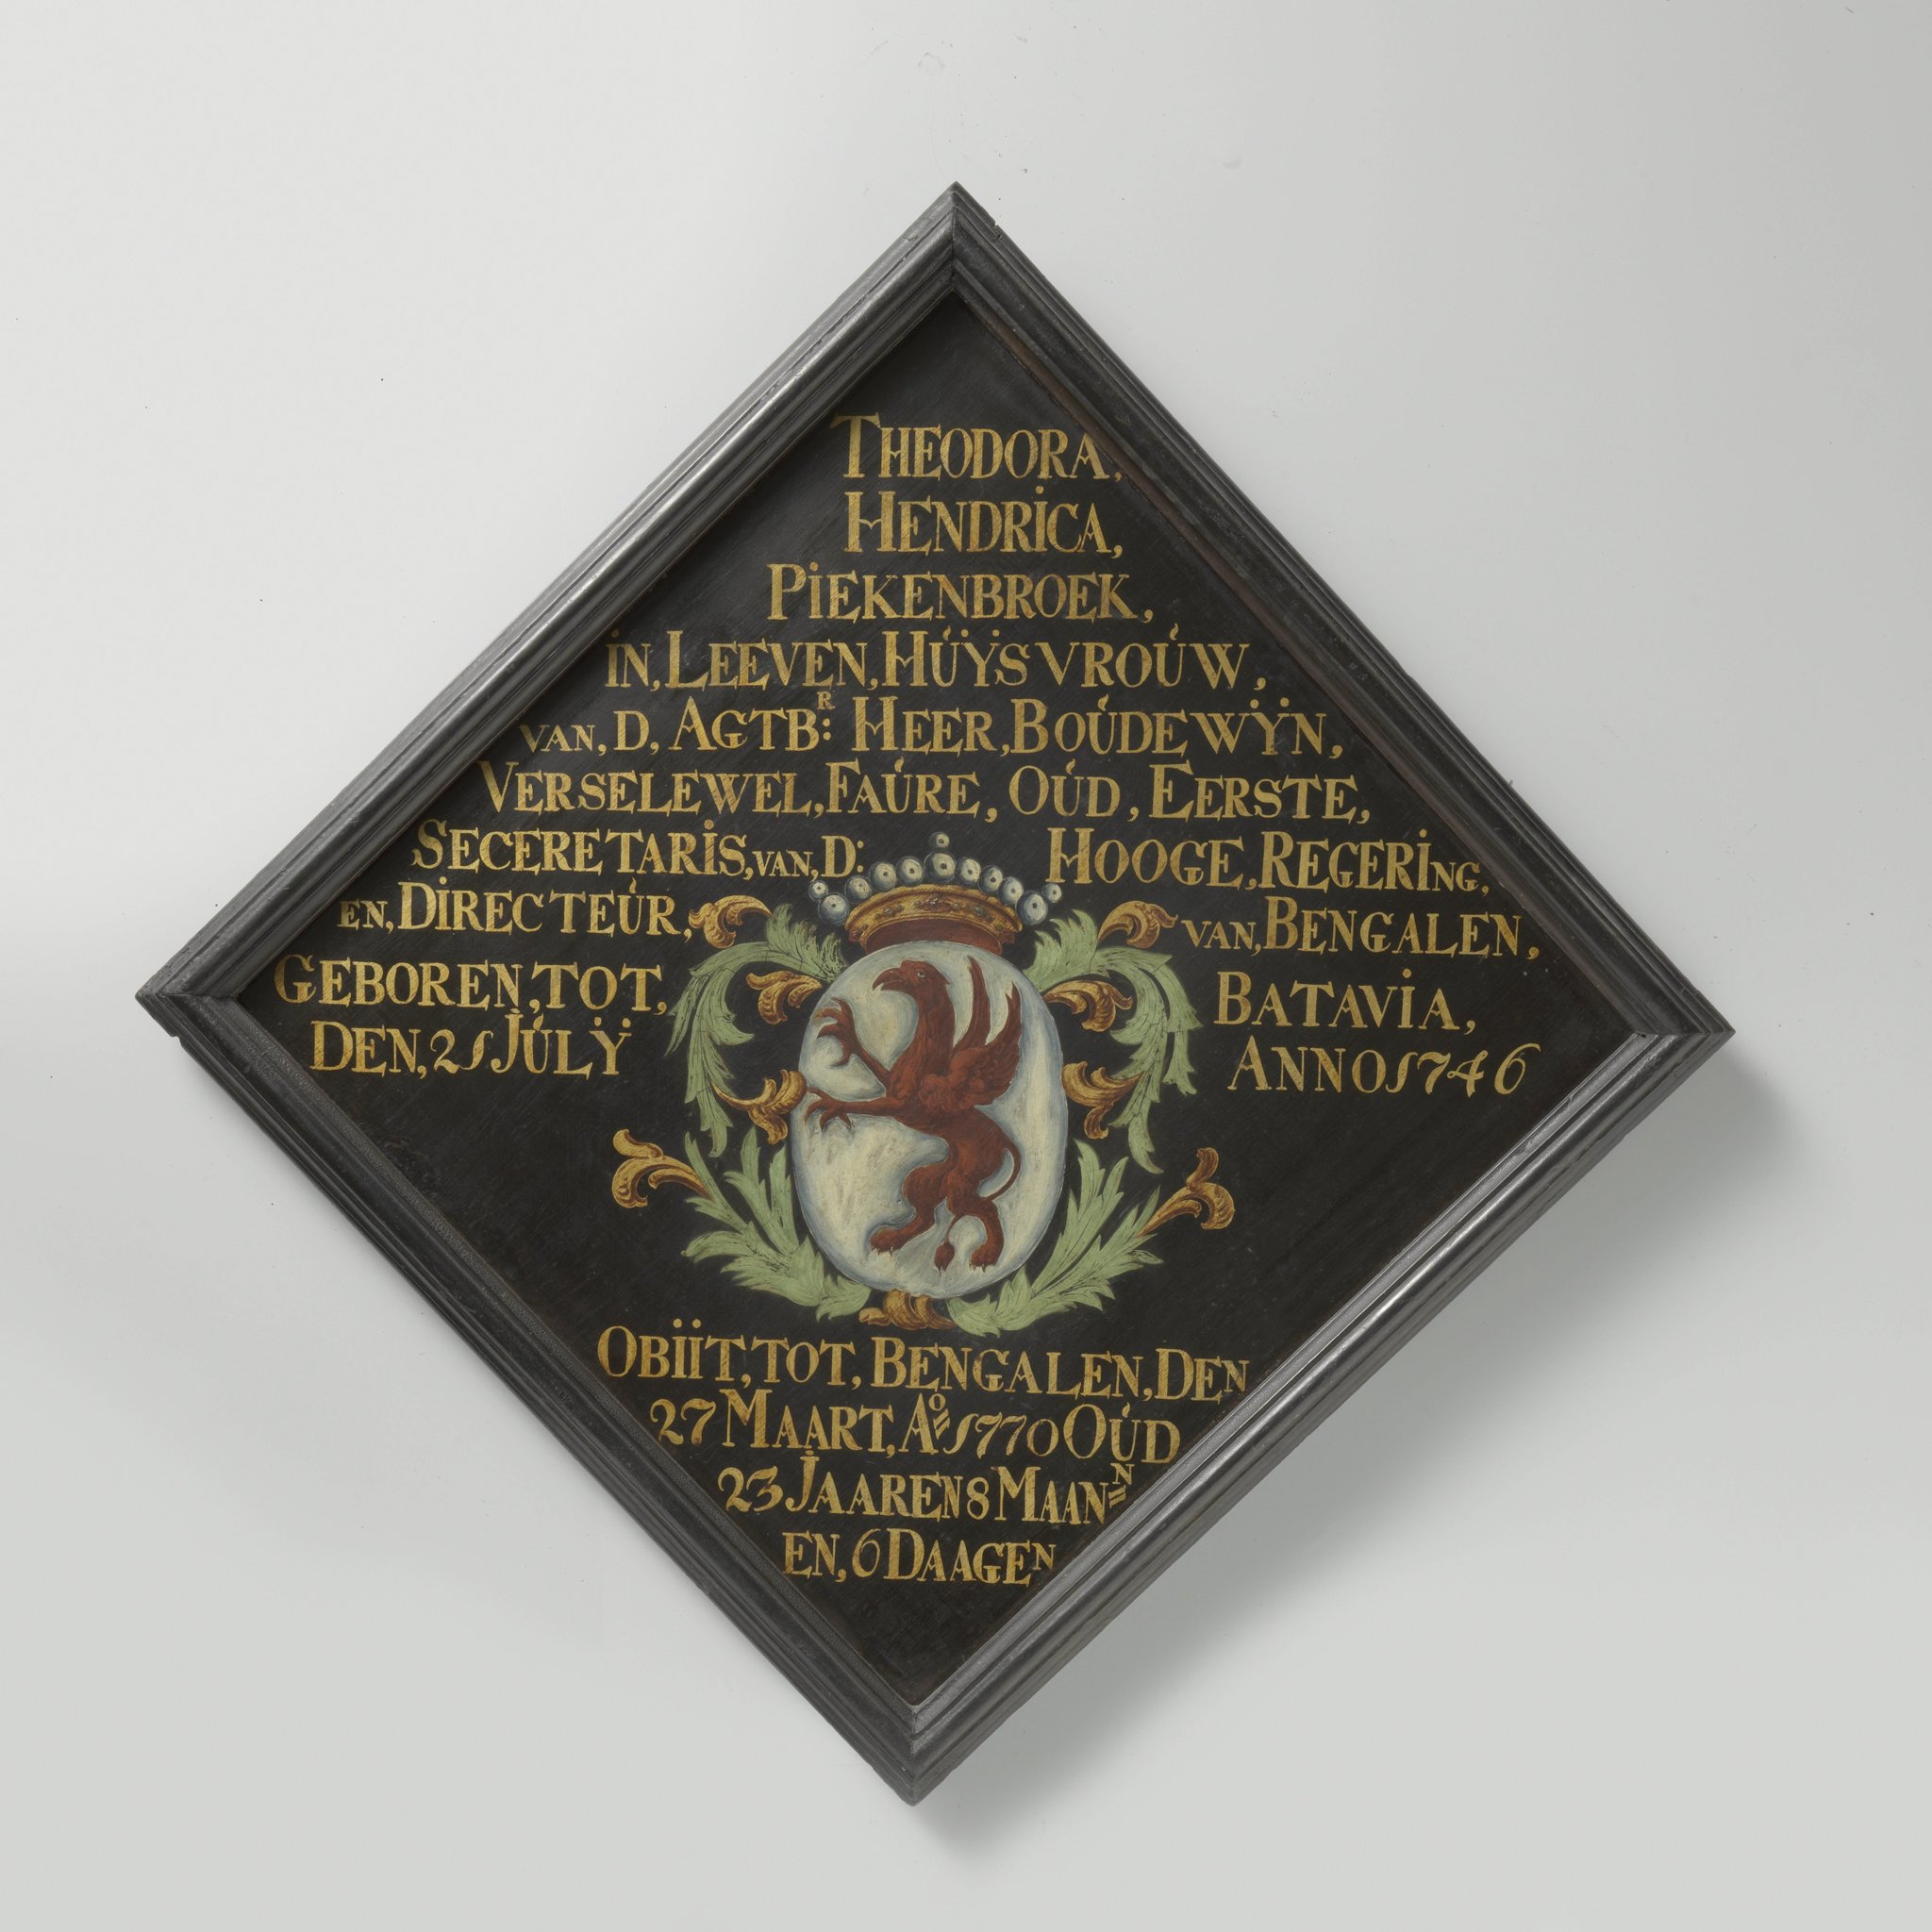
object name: rouwbord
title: Grafbord van Theodora Hendrica Piekenbroek (1746-70), echtgenote van Boudewijn Versewel Faure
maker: Anonymous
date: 1770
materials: panel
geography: bengal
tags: armorial bearing, heraldry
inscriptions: inscription: ‘Theodora Hendrika Piekenbroek in leeven huijsvrouw van d. Agtbr: Heer, Boudewijn Verselewel Fauré, Oud Eerste Secretaris van D: Hooge Regering en Directeur van Bengalen, Geboren tot Batavia Den 21 Julij Anno 1746 Obiit tot Bengalen Den 27 Maart Ao 1770 Oud 23 Jaaren 8 Maann en 6 Daagen’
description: Epitaph from the church in Chinsura, second half 18th century. Chinsura in Bengal (Northeast India) was one of the key trading posts of the VOC. Under its director, George Louis Vernet, a church was built at Chinsura in 1767. As was traditional in European churches, memorials were placed on the walls to commemorate high-ranking officials who had died in Asia in the service of the Company. Far right: Vernet's epitaph - the director died in Batavia in 1775. The second from the left is the epitaph of Theodora Hendrica Piekenbroek. She was the daughter of a Dutch preacher from Batavia. After marrying Boudewijn Versewel Faure - whose memorial is also shown here - she moved to Chinsura, where they both died within a short space of time. Theodora was only 23: the death rate among Europeans in Bengal was high.